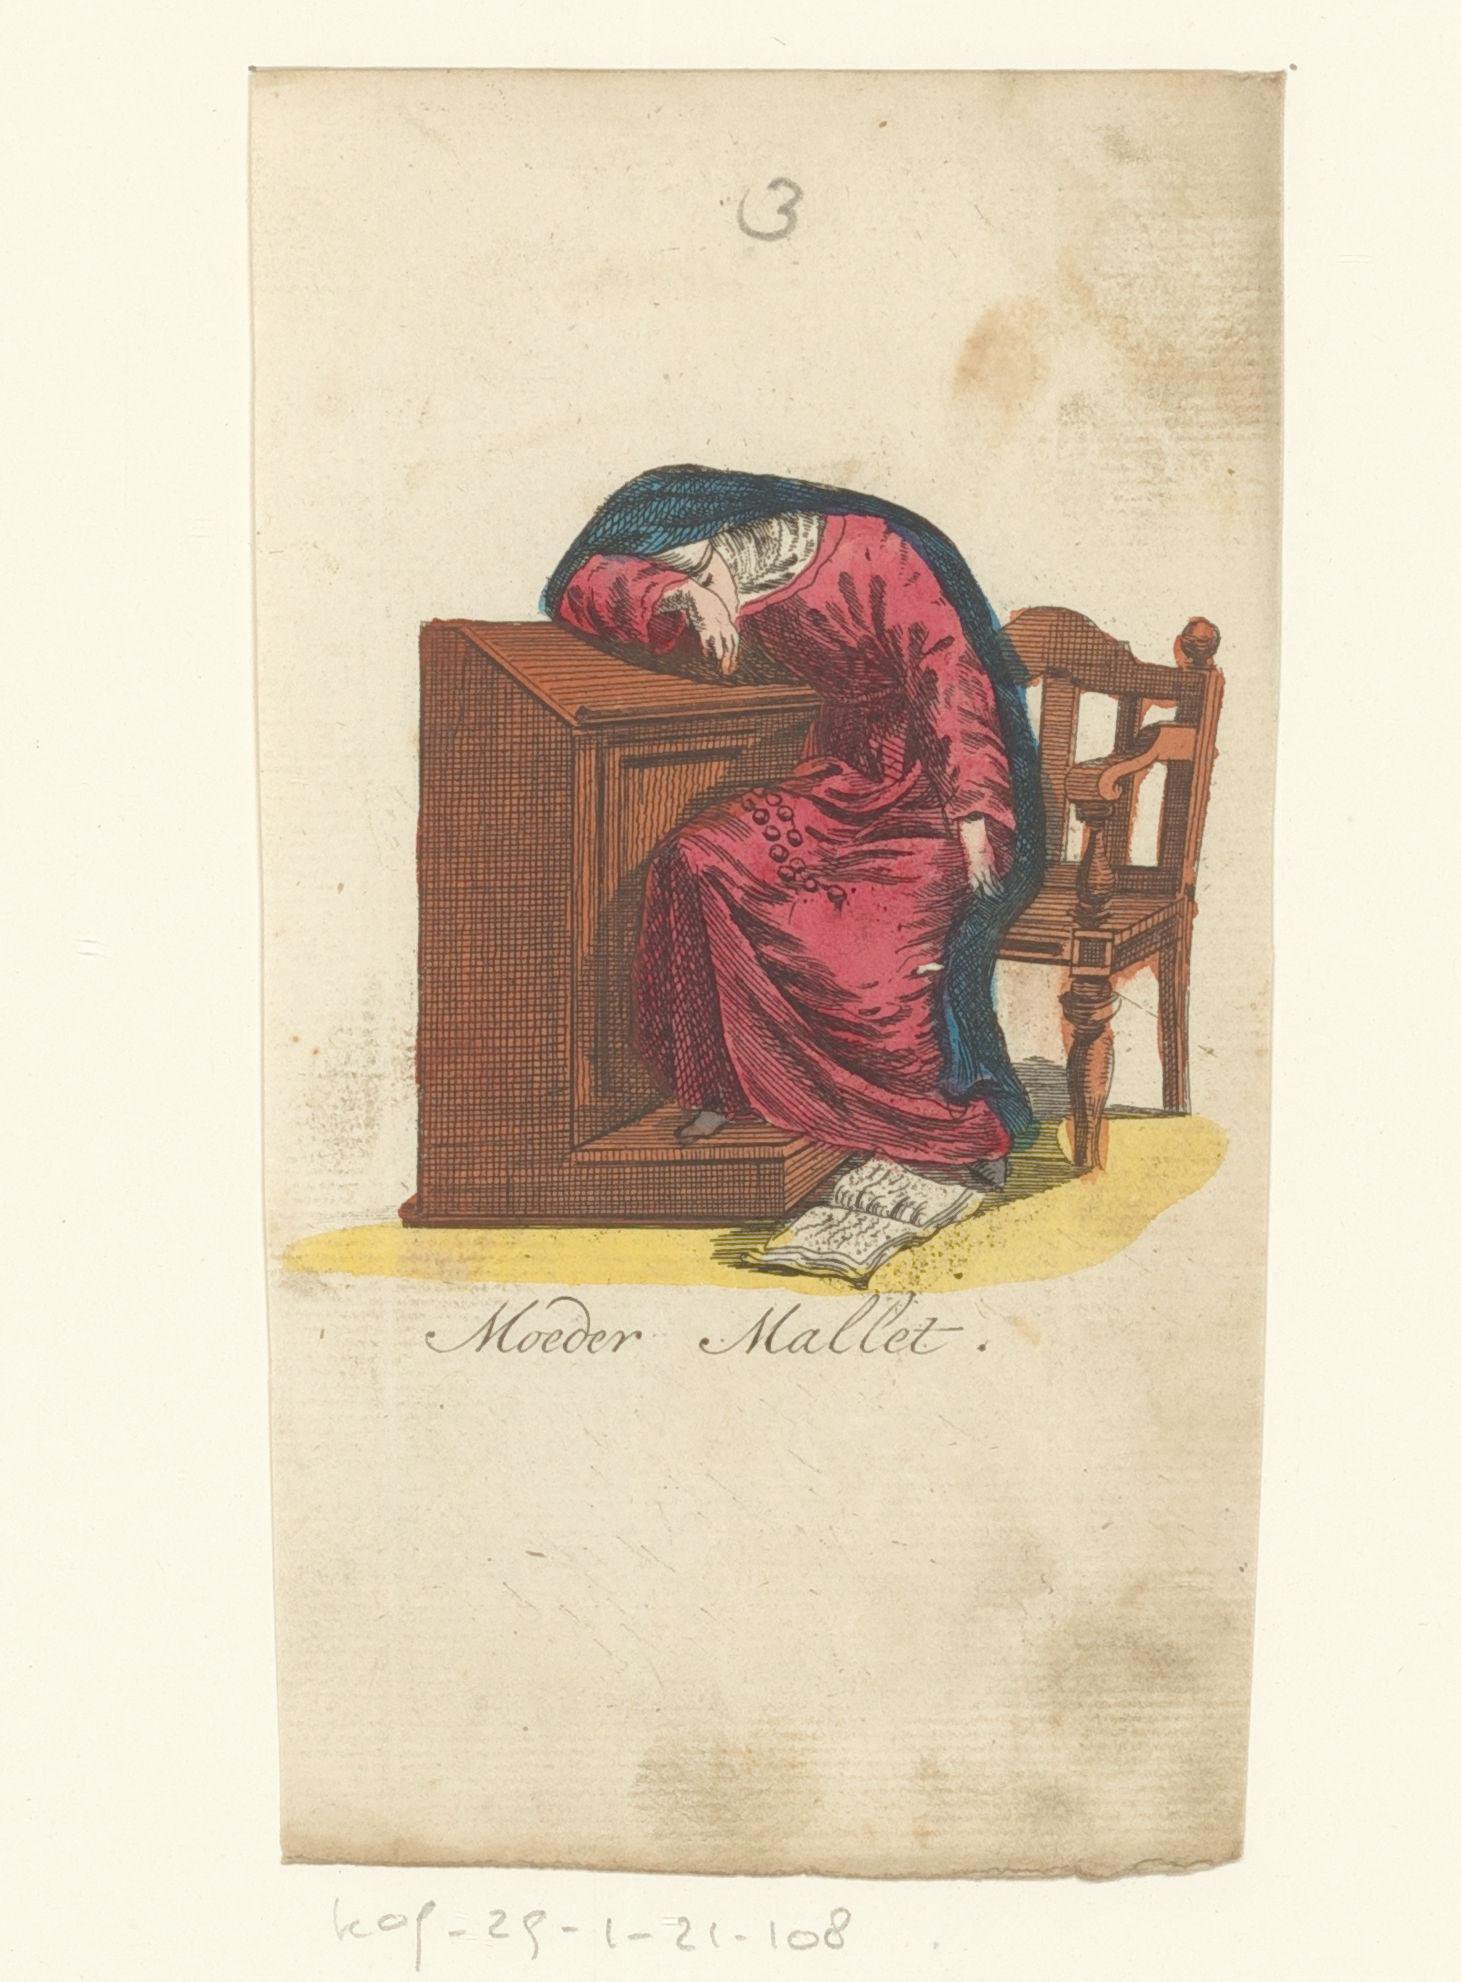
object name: print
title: Moeder Mallet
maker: Anonymous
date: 1793-1800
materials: paper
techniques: engraving, etching, hand coloring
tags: writing-table, writing-desk, book, resting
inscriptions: collector's mark: Lugt 1641a, collector's mark: Lugt 1641, stamp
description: Prent waarschijnlijk uit: De vrolijke Zeden-Meester, voor kinderen. Amsterdam: Johannes Roelof Poster, 1800. Of een andere editie van deze uitgave. Volgens de Atlas van Stolk ook gebruikt in: De nieuwe toverlantaarn. Amsterdam: s.n., 1797.